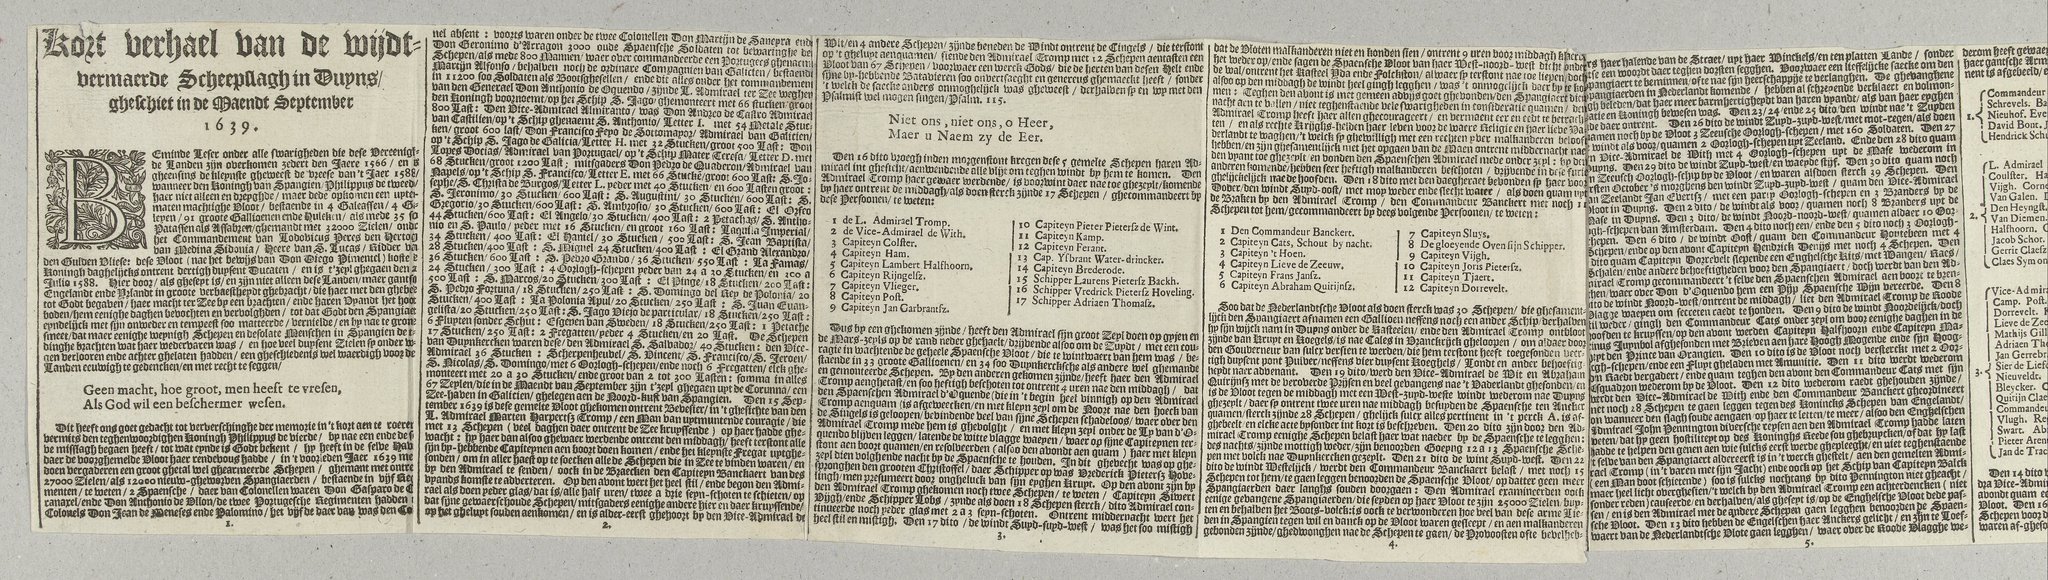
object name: text sheet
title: Kort verhael van de wijdt-vermaerde Scheepslagh in Duyns / gheschiet in de Maendt September 1639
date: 1640-1643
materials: paper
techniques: letterpress printing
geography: amsterdam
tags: brielle, maarten harpertszoon tromp, battle of the downs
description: Grote voorstelling van de zeeslag bij Duins tussen de Spaanse vloot onder bevel van Antonio de Oquendo en de Staatse vloot onder Maarten Harpertsz. Tromp, 21 oktober 1639. Tekstblad om onder de prent te plakken, met een beschrijving van de gebeurtenissen en waarin opgenomen een verklaring van de letters in de voorstelling. Tekst in 10 kolommen (genummerd 1-9) op 4 bladen aan elkaar geplakt, op de laatste twee kolommen een vers op het mistig weer in Duins op de dag van de slag. Ongemonteerde ensemble bestaande uit 7 genummerde platen, de zwarte stroken met de titel en tekstblad met de beschrijving.